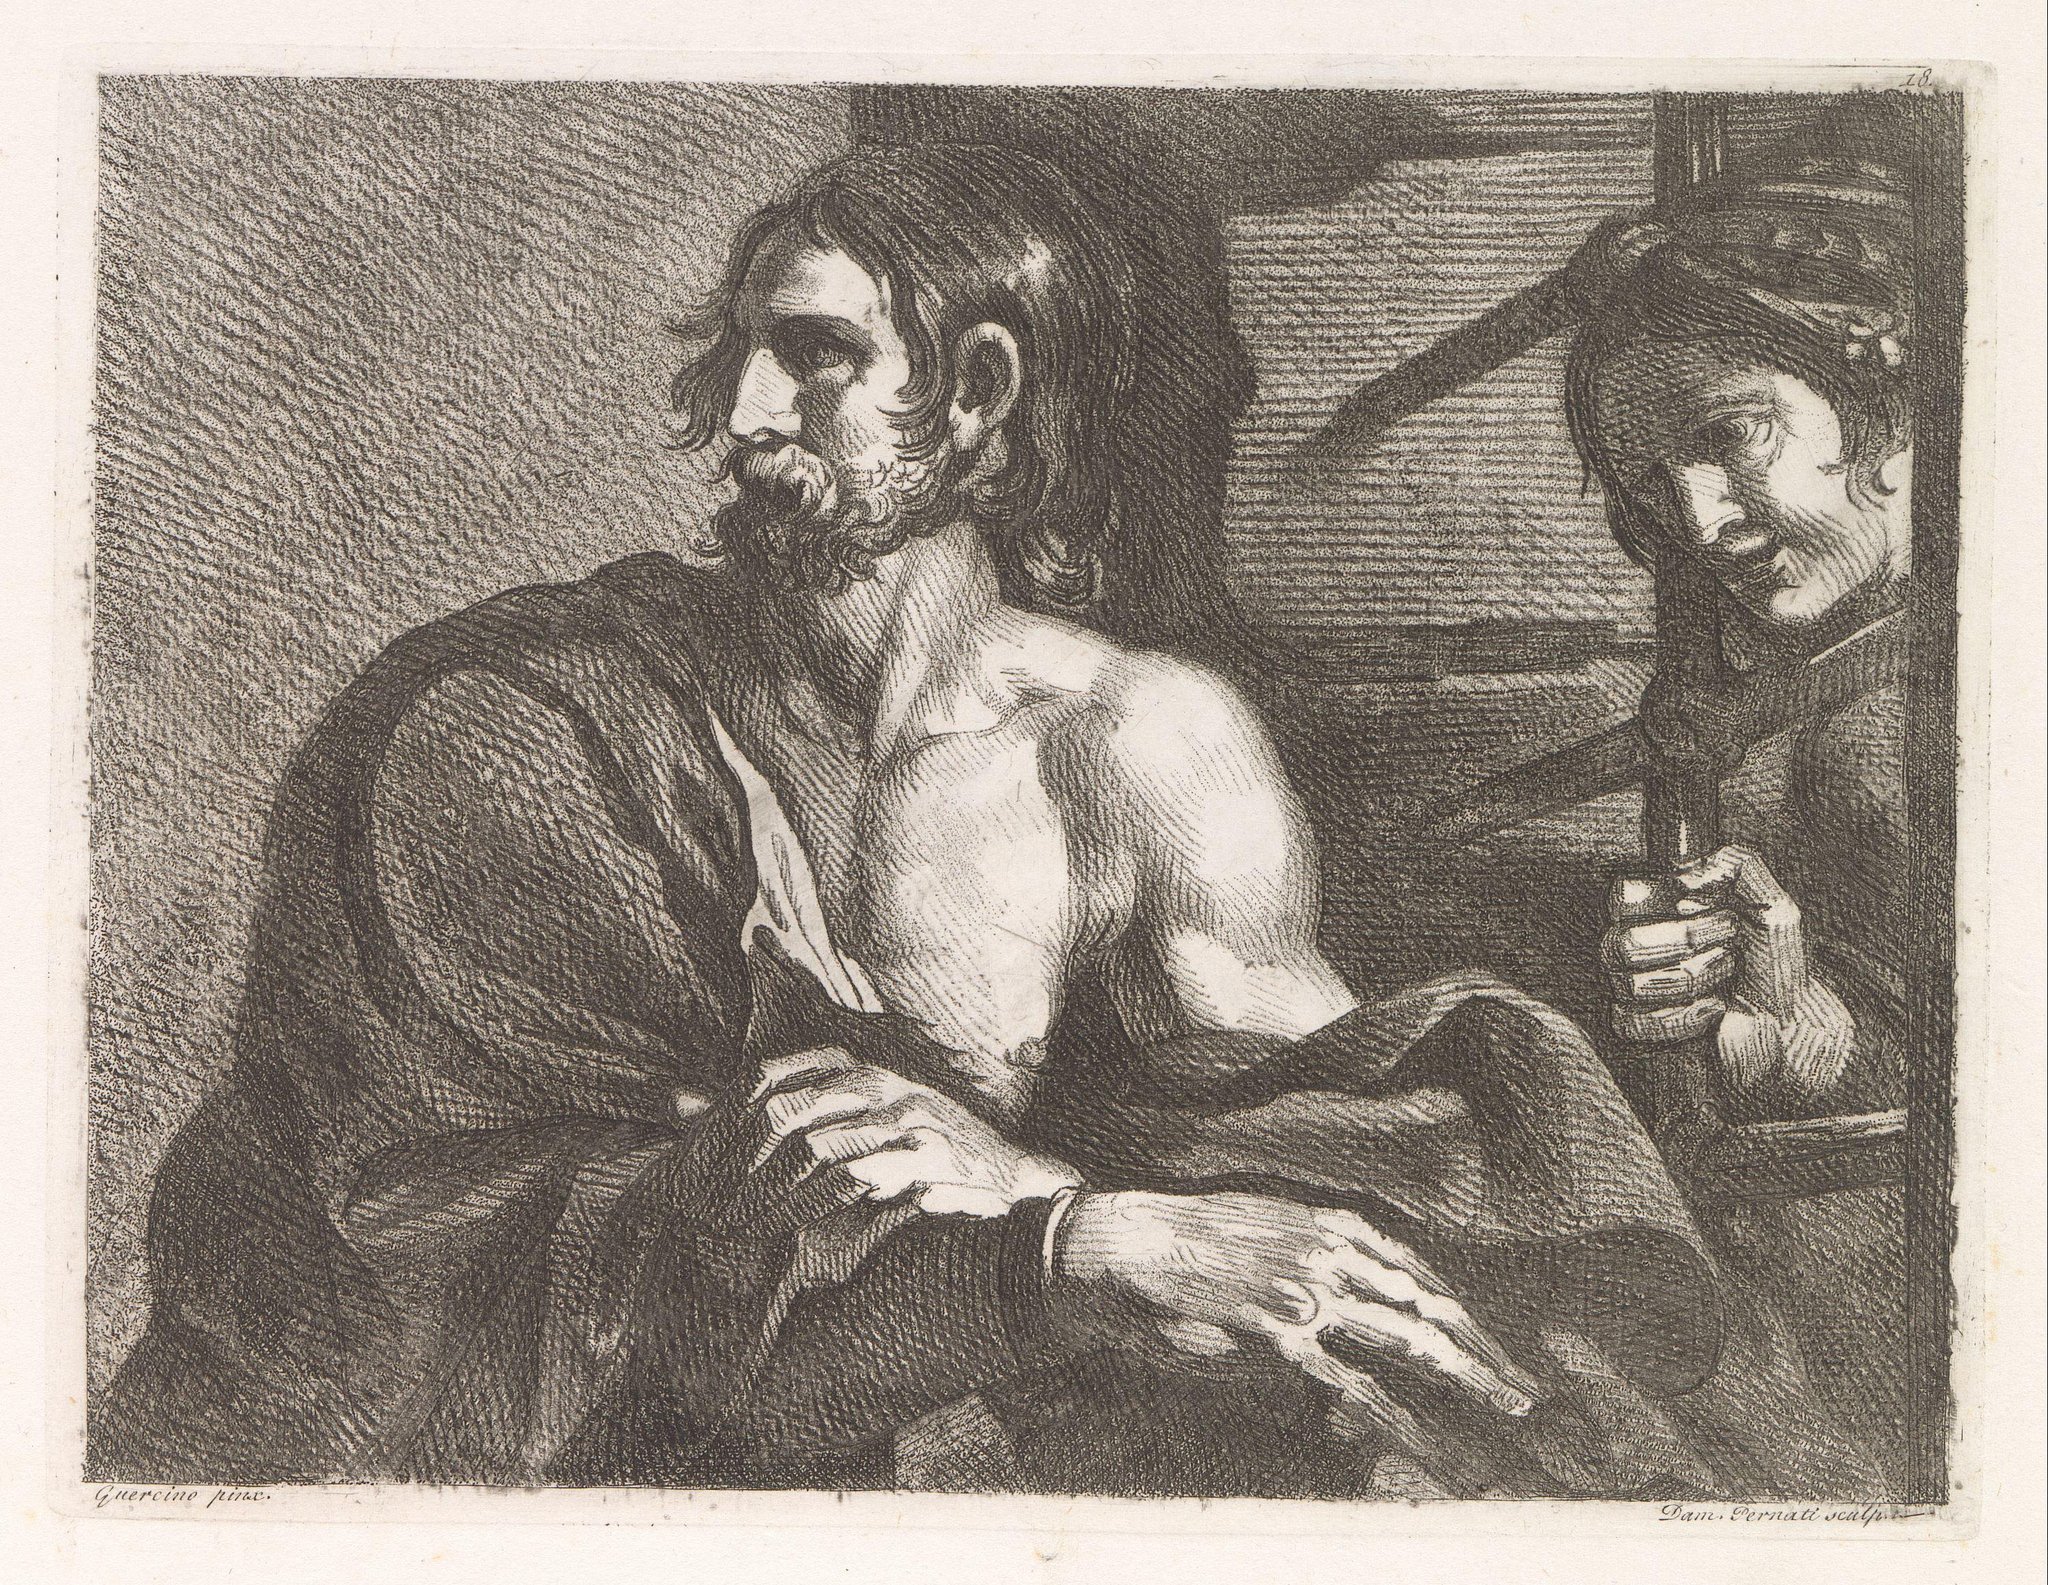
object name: print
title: Saint John The Baptist In Prison Visited By Salome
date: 1804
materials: paper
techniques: etching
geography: italy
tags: john the baptist in prison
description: Salome bezoekt Johannes de Doper in de gevangenis. Prent nr. 18 op blad 10 in het album 'Raccolta di Soggetti Pittorici', een prentalbum met 42 genummerde etsen op 28 pagina's van Luigi Sabatelli (I) zelf en van leerlingen naar diens ontwerp.